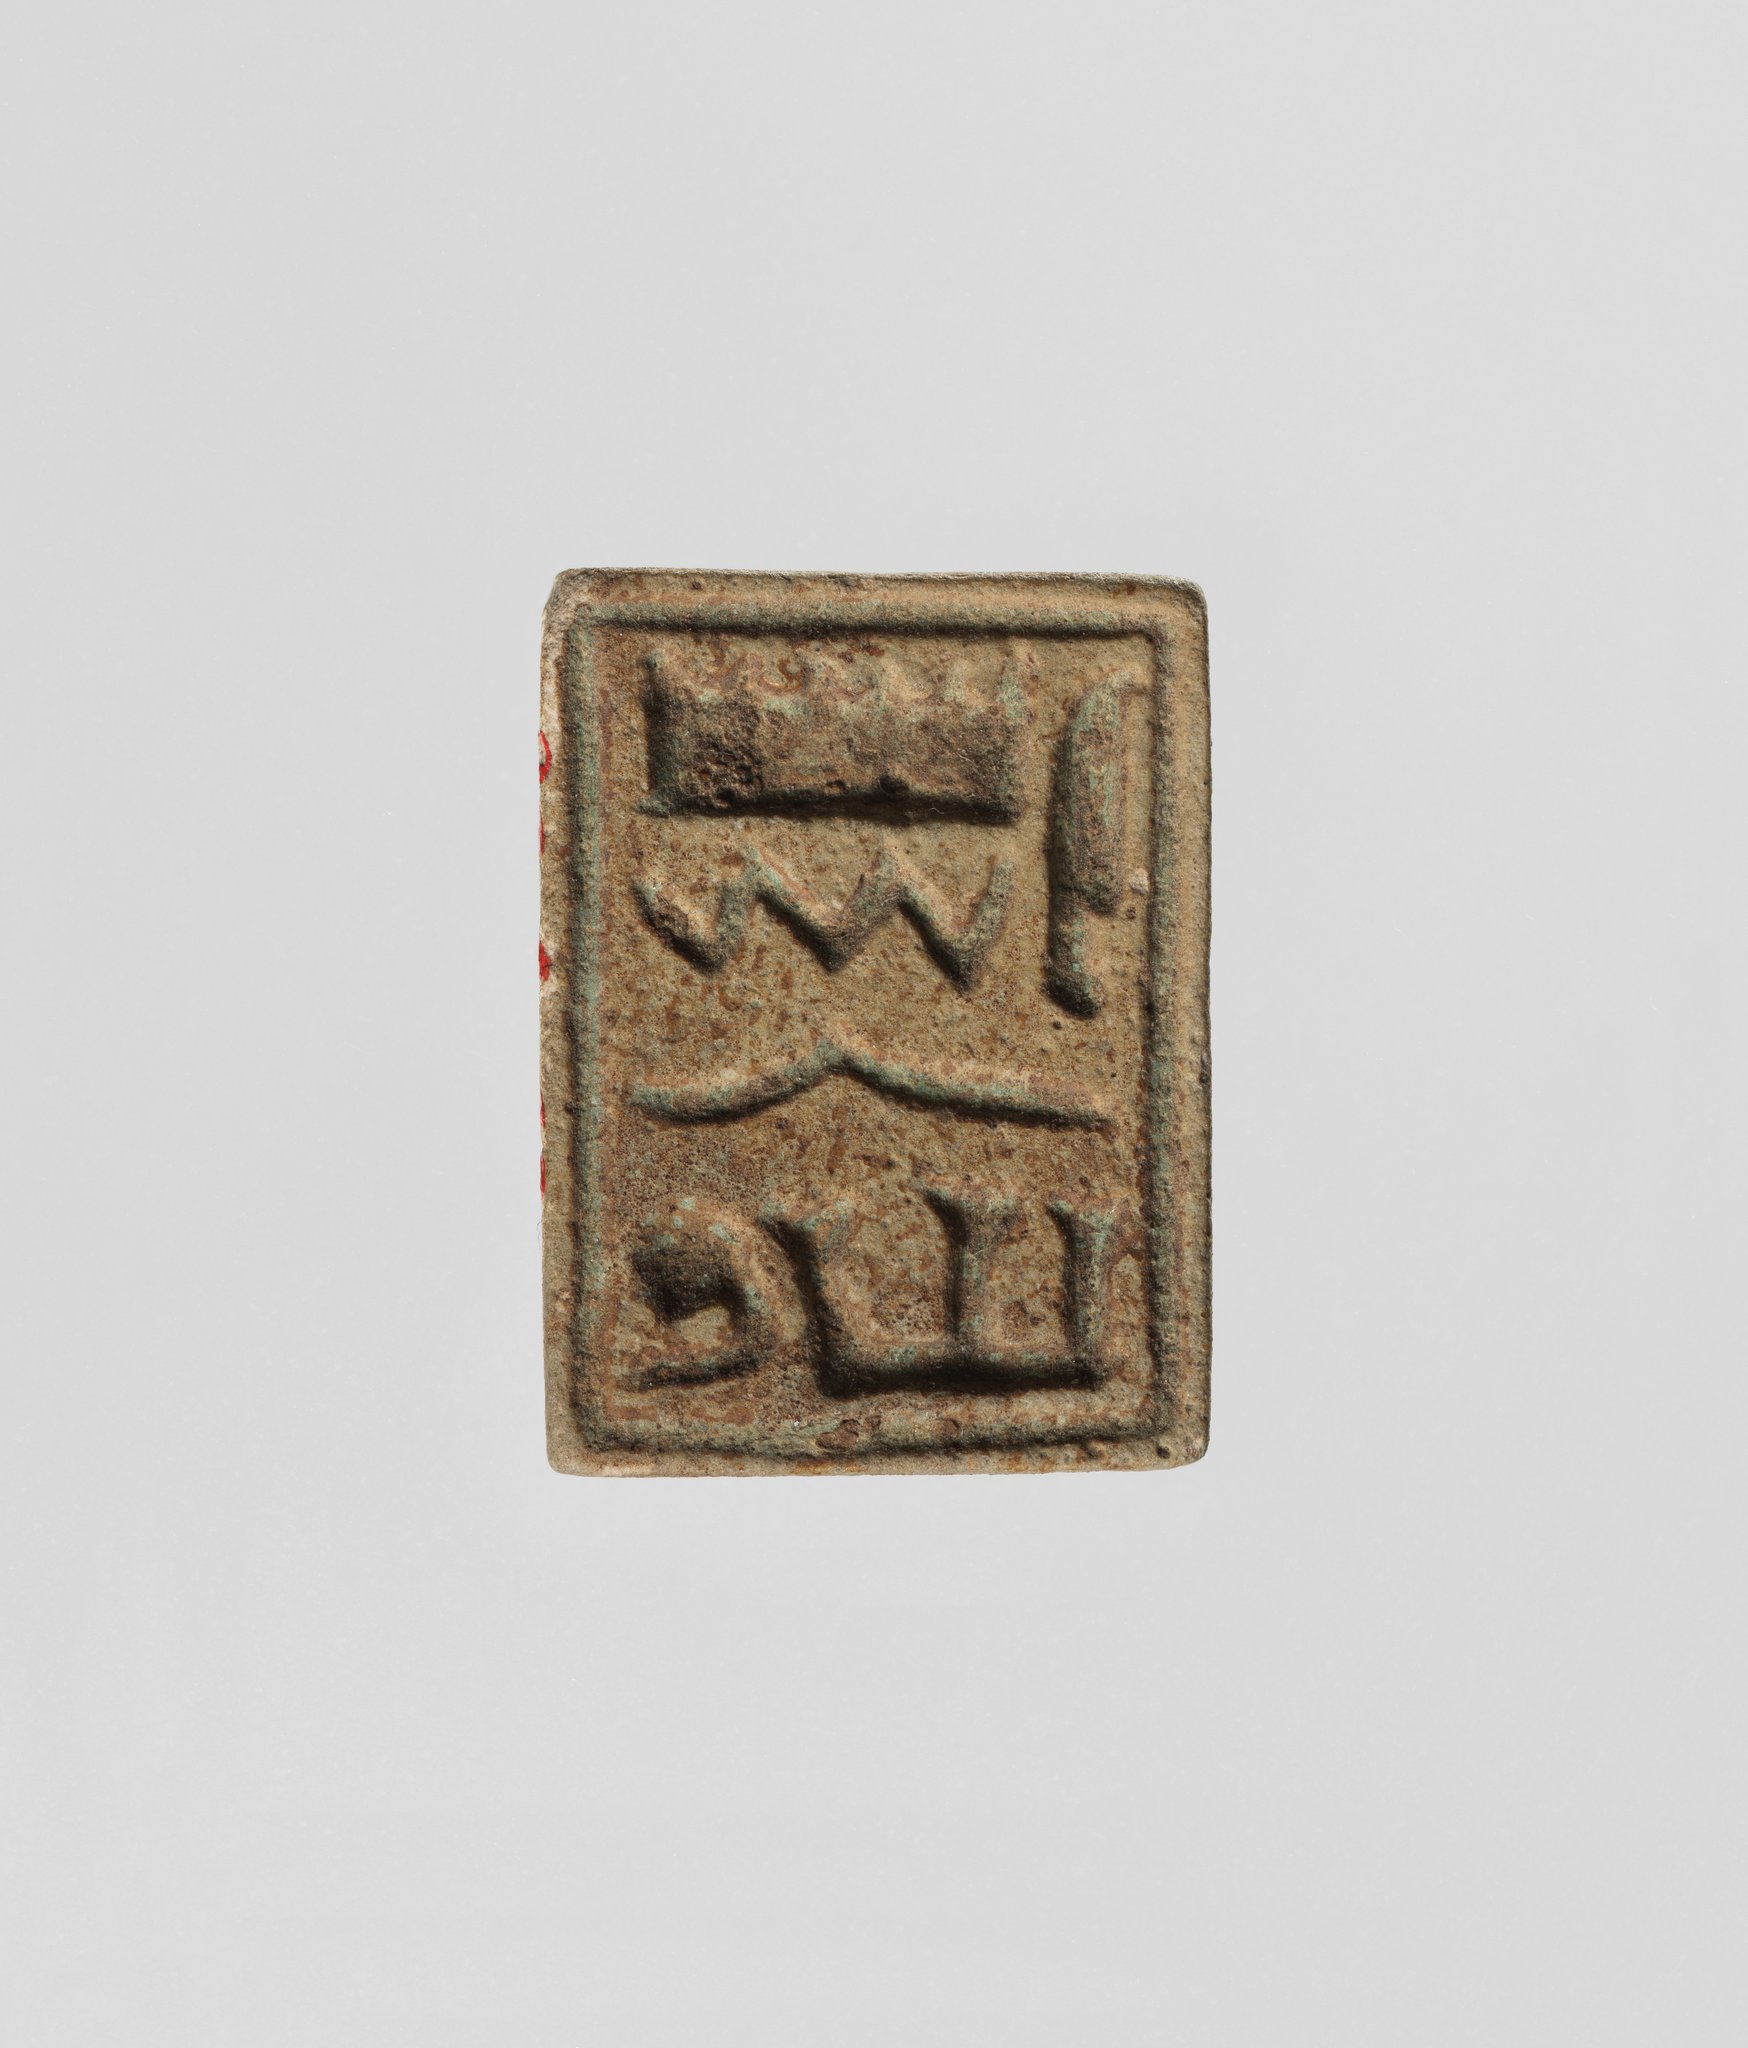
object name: seal plaque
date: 750-300 BCE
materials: faience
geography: nubia